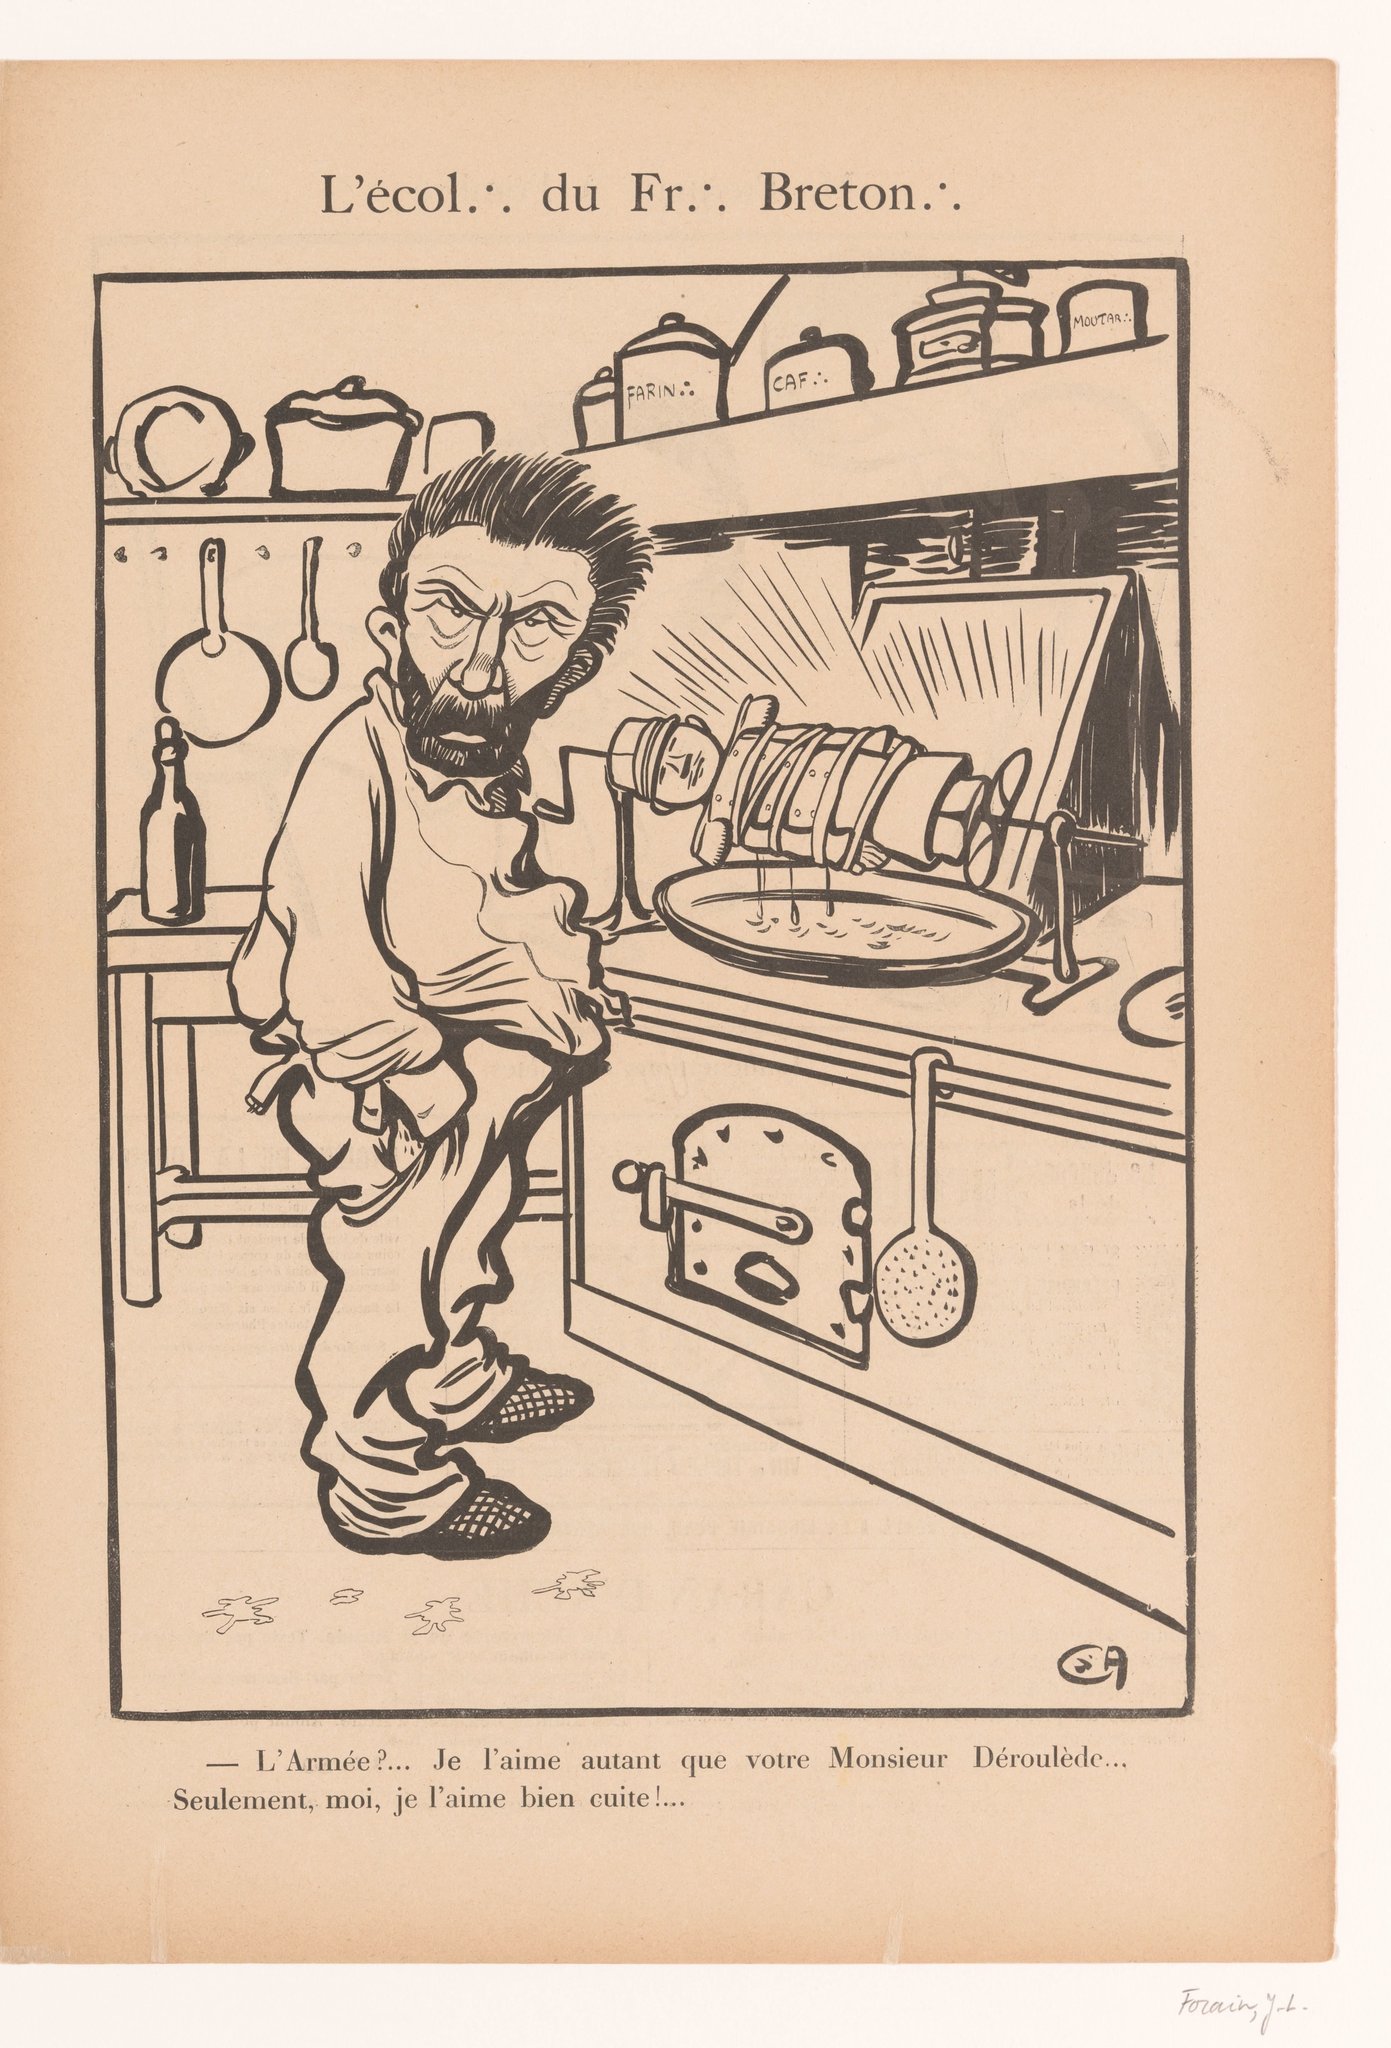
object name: magazine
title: Karikatuur van Paul Déroulède als een rollade aan het spit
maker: caran dache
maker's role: draughtsman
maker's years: 1859-1909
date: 1898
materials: paper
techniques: lithograph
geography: paris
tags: paris, politician, historical persons, spit ~ cooking, political caricatures and satires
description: Prent gebruikt voor: Psst...!, nr. 35, 1 oktober 1898. Psst..! was een politieke weekkrant met antisemitische en anti-Dreyfus cartoons.